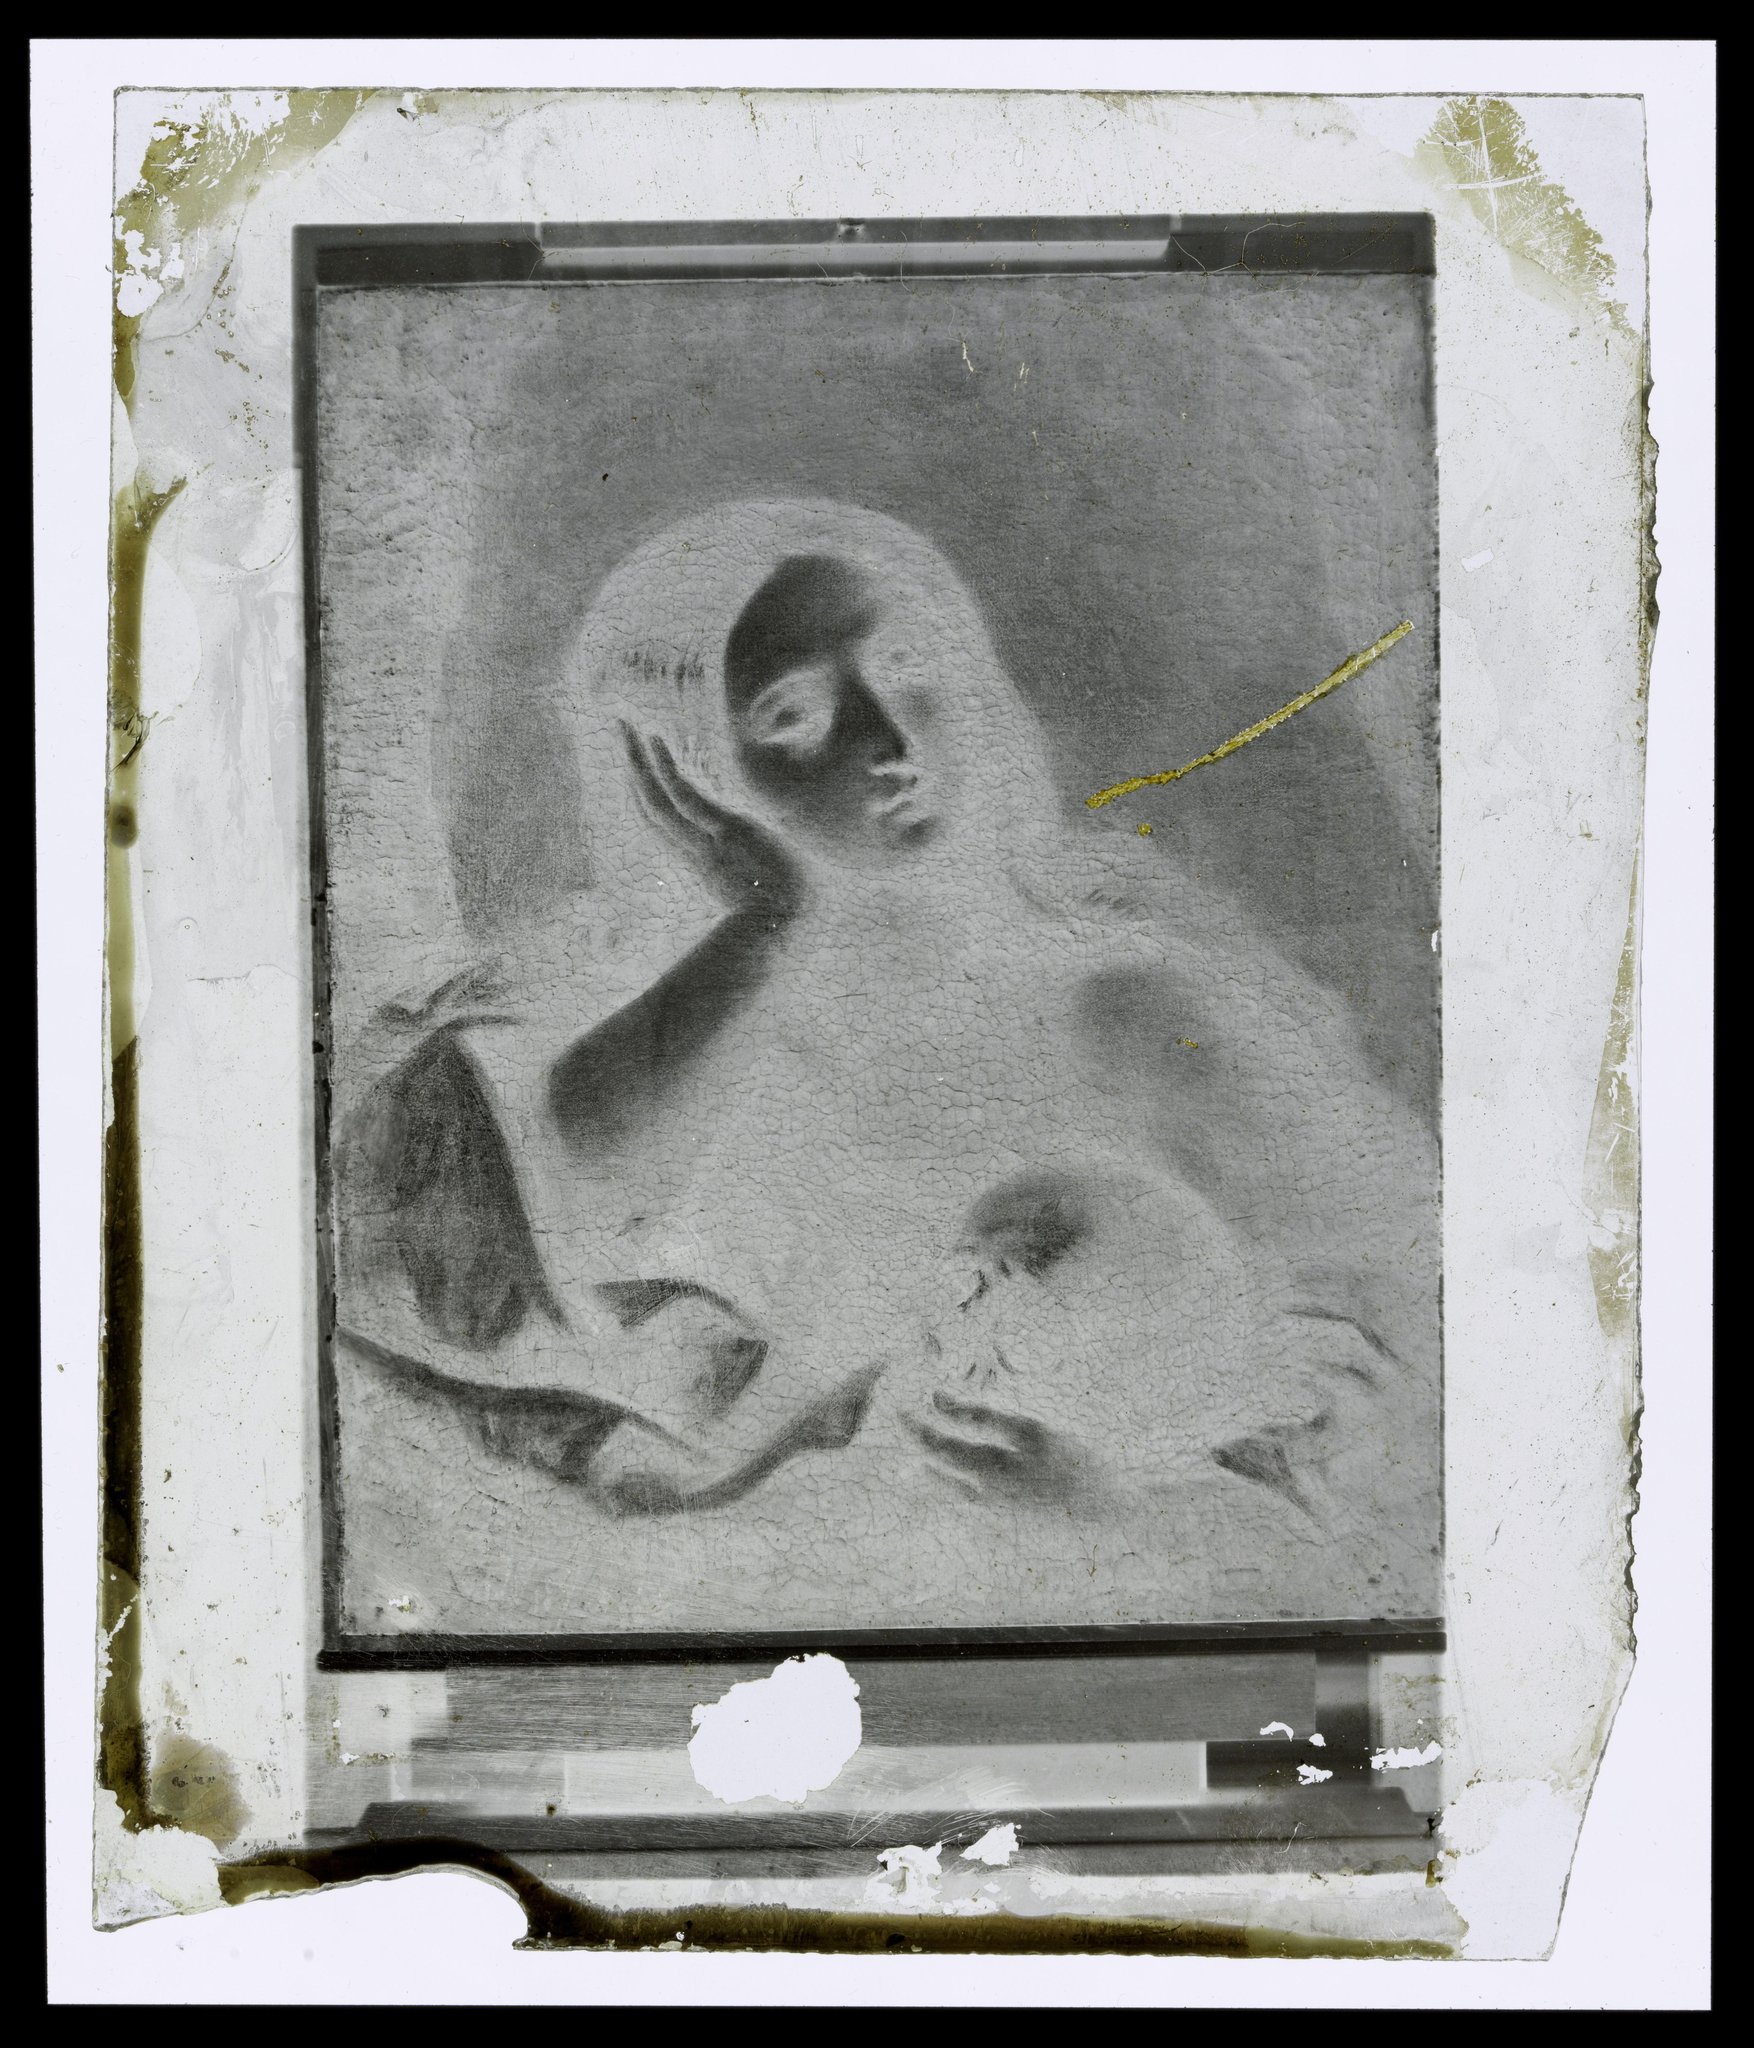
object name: reproduction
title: Fotoreproductie van een schilderij van een vrouw met menselijke schedel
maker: laurens lodewijk kleijn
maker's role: draughtsman, painter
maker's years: 1826-1909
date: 1865-1900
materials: glass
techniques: collodion process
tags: adult woman, (human) skull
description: Onderdeel van een groep glasnegatieven uit de nalatenschap van de schilder Laurens Lodewijk Kleijn, met stillevens, portretten, zelfportretten en kunstreproducties.